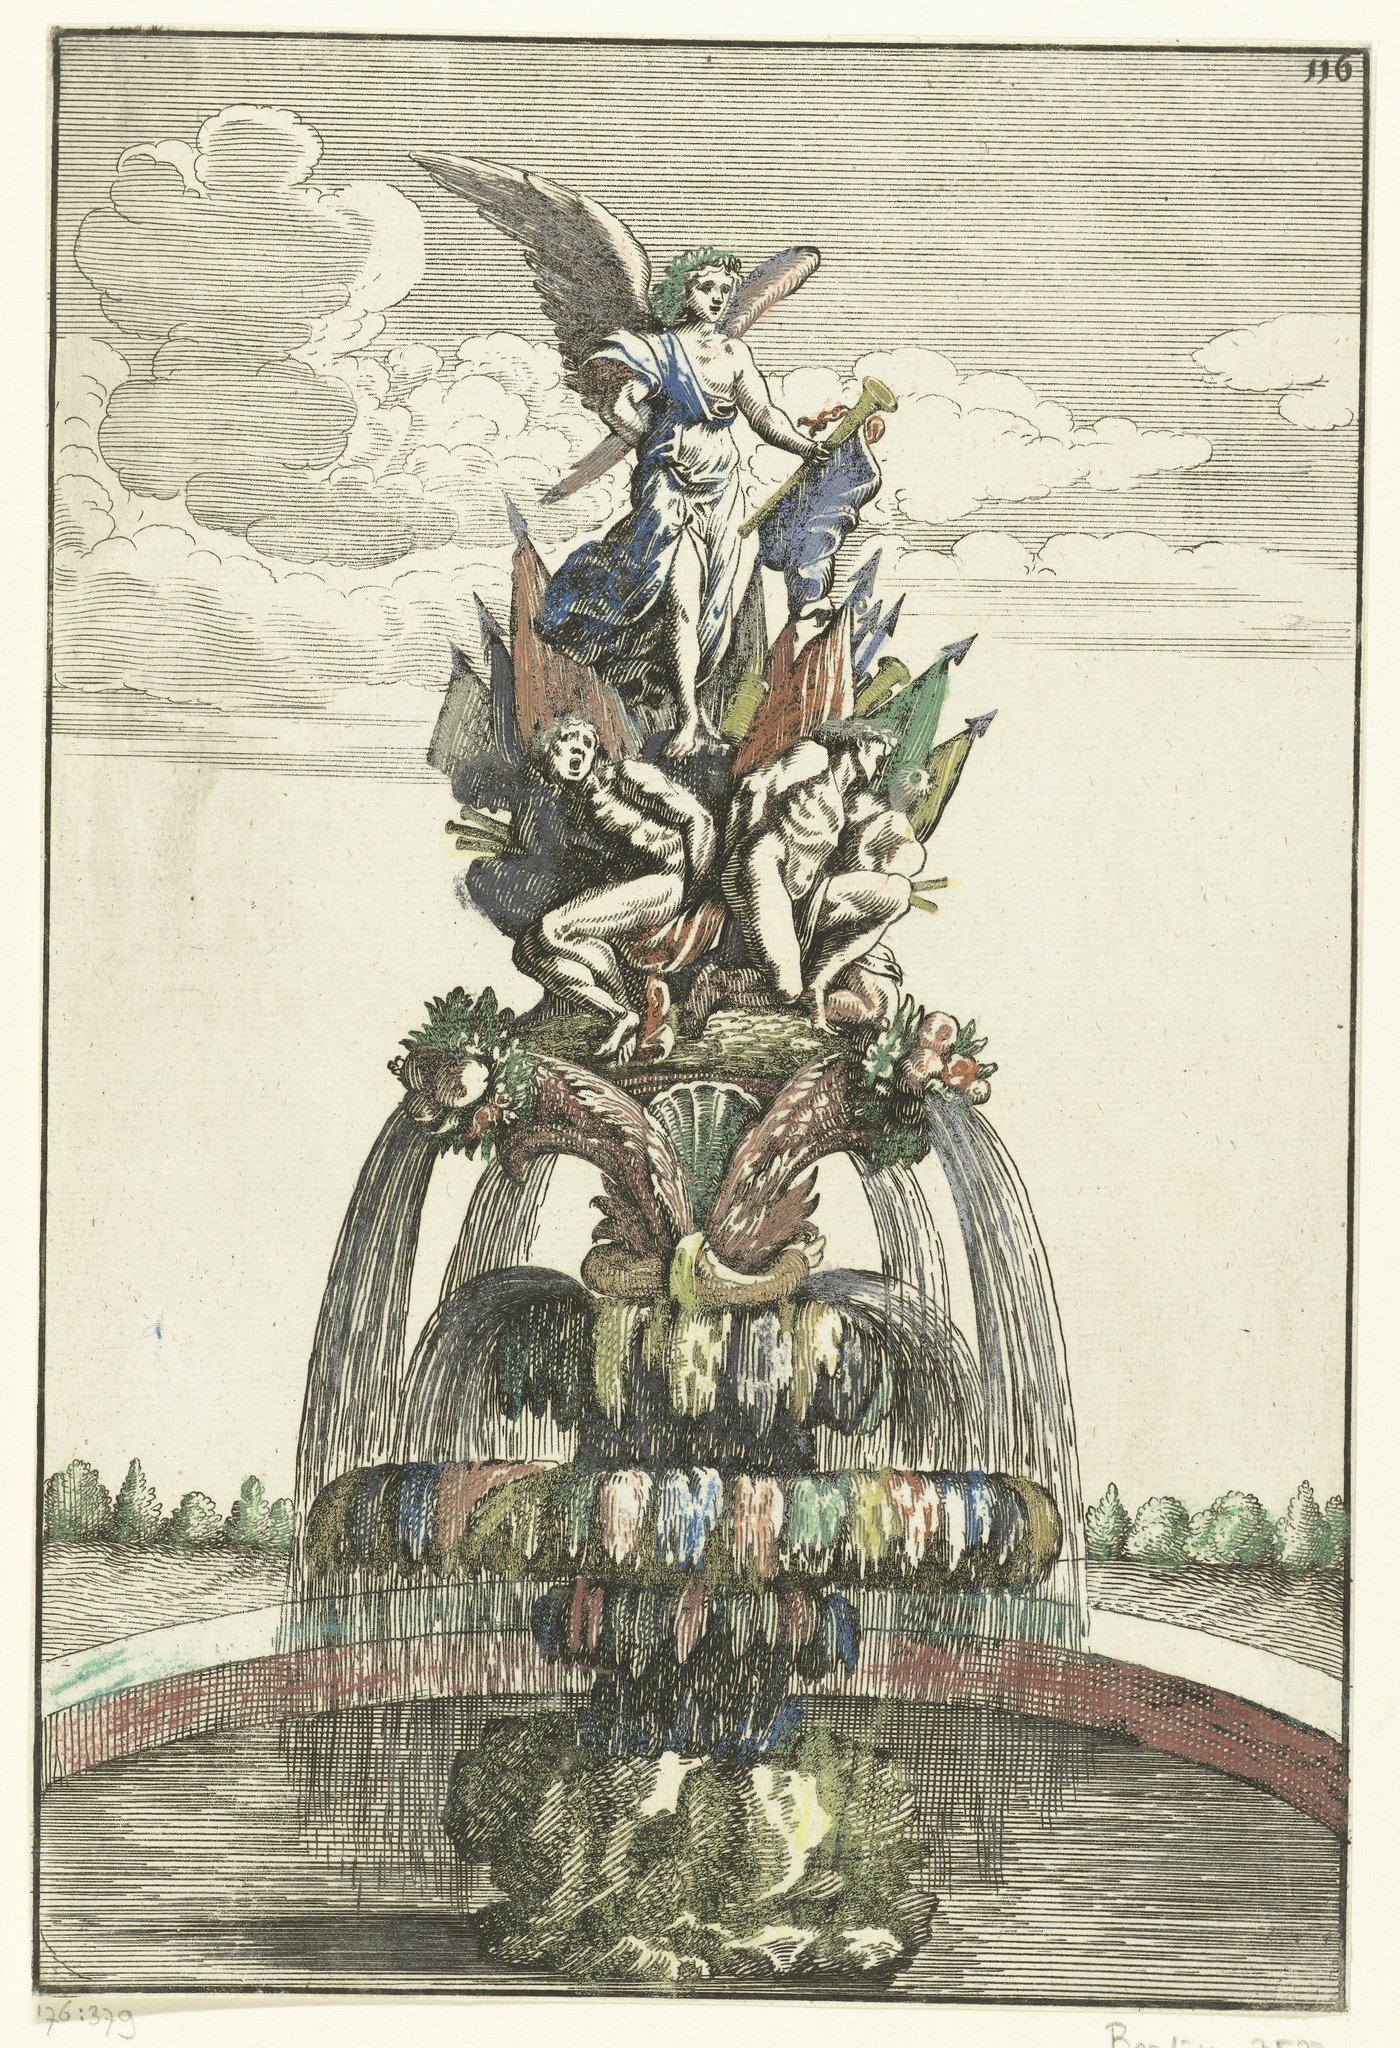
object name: print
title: Fontein met beeld van Victoria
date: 1664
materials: paper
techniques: etching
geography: germany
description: Victoria staat boven vier krijgsgevangenen op een hoog voetstuk, gedecoreerd net schelpmotieven en hoorns des overvloeds.